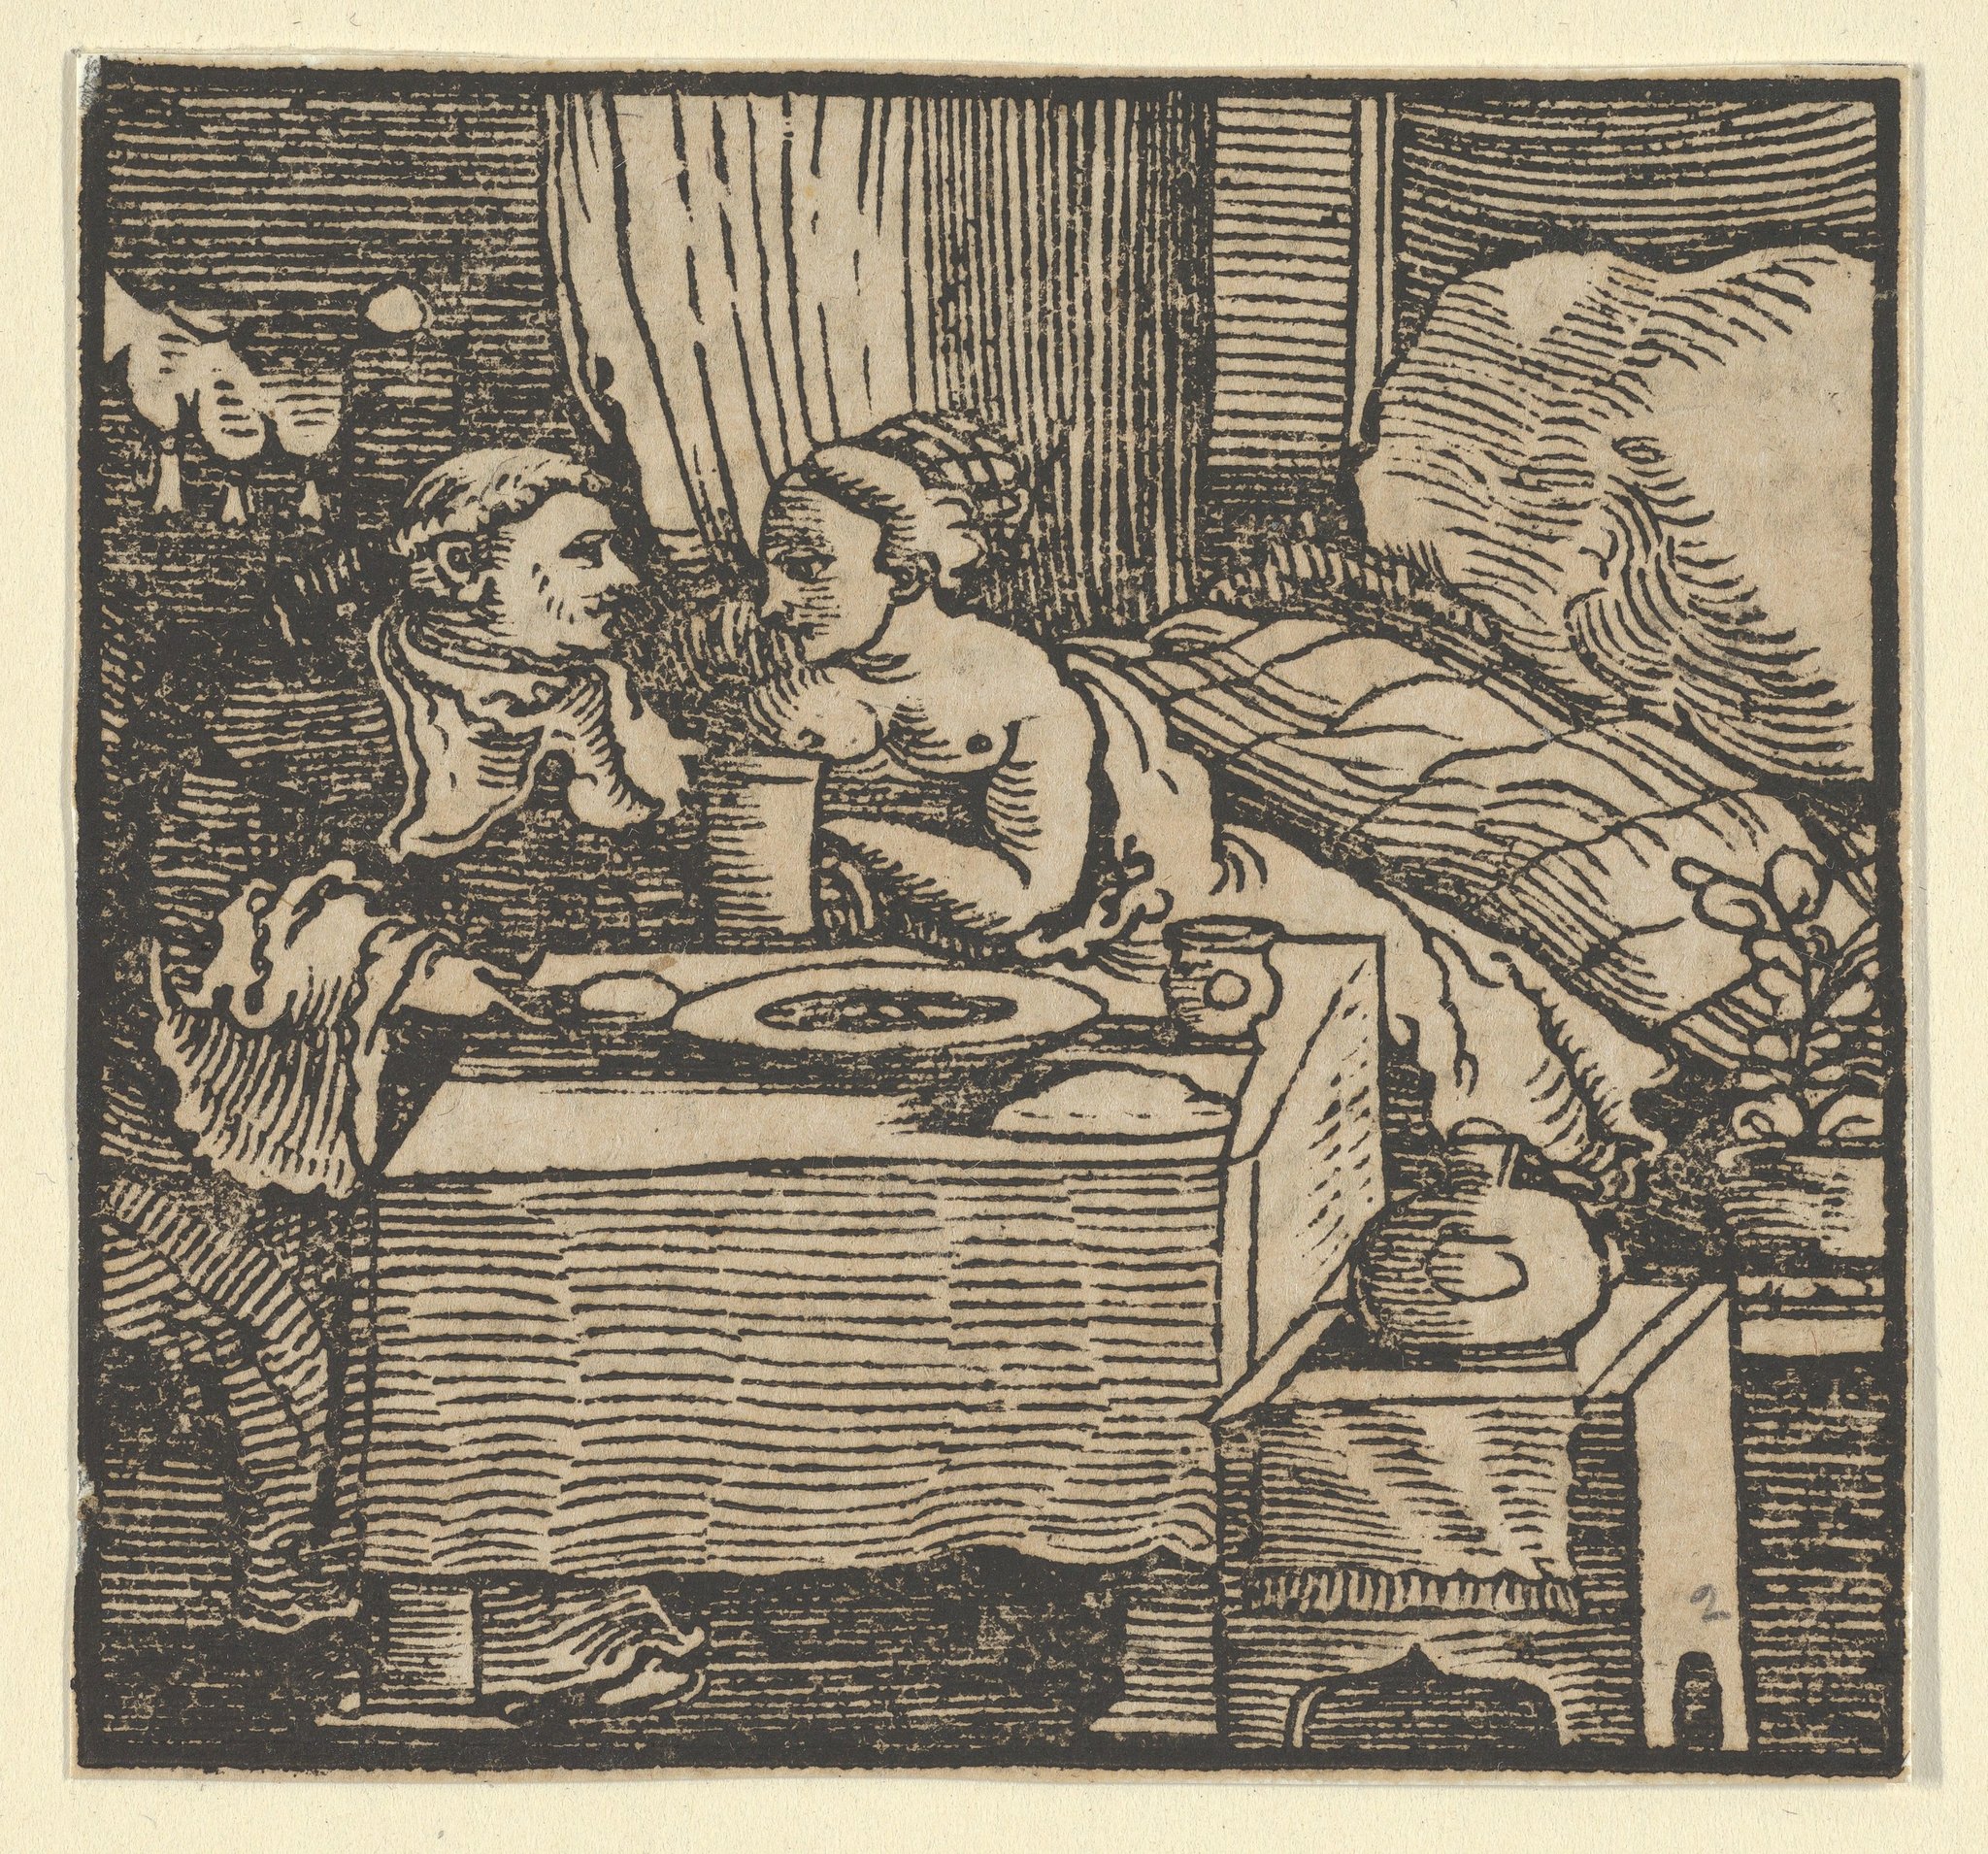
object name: print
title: The Nude Girl and the Abbot, from The Decameron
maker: hans schäufelein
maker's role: artist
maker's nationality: german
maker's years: 1480-1540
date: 1534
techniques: woodcut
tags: men,female nudes